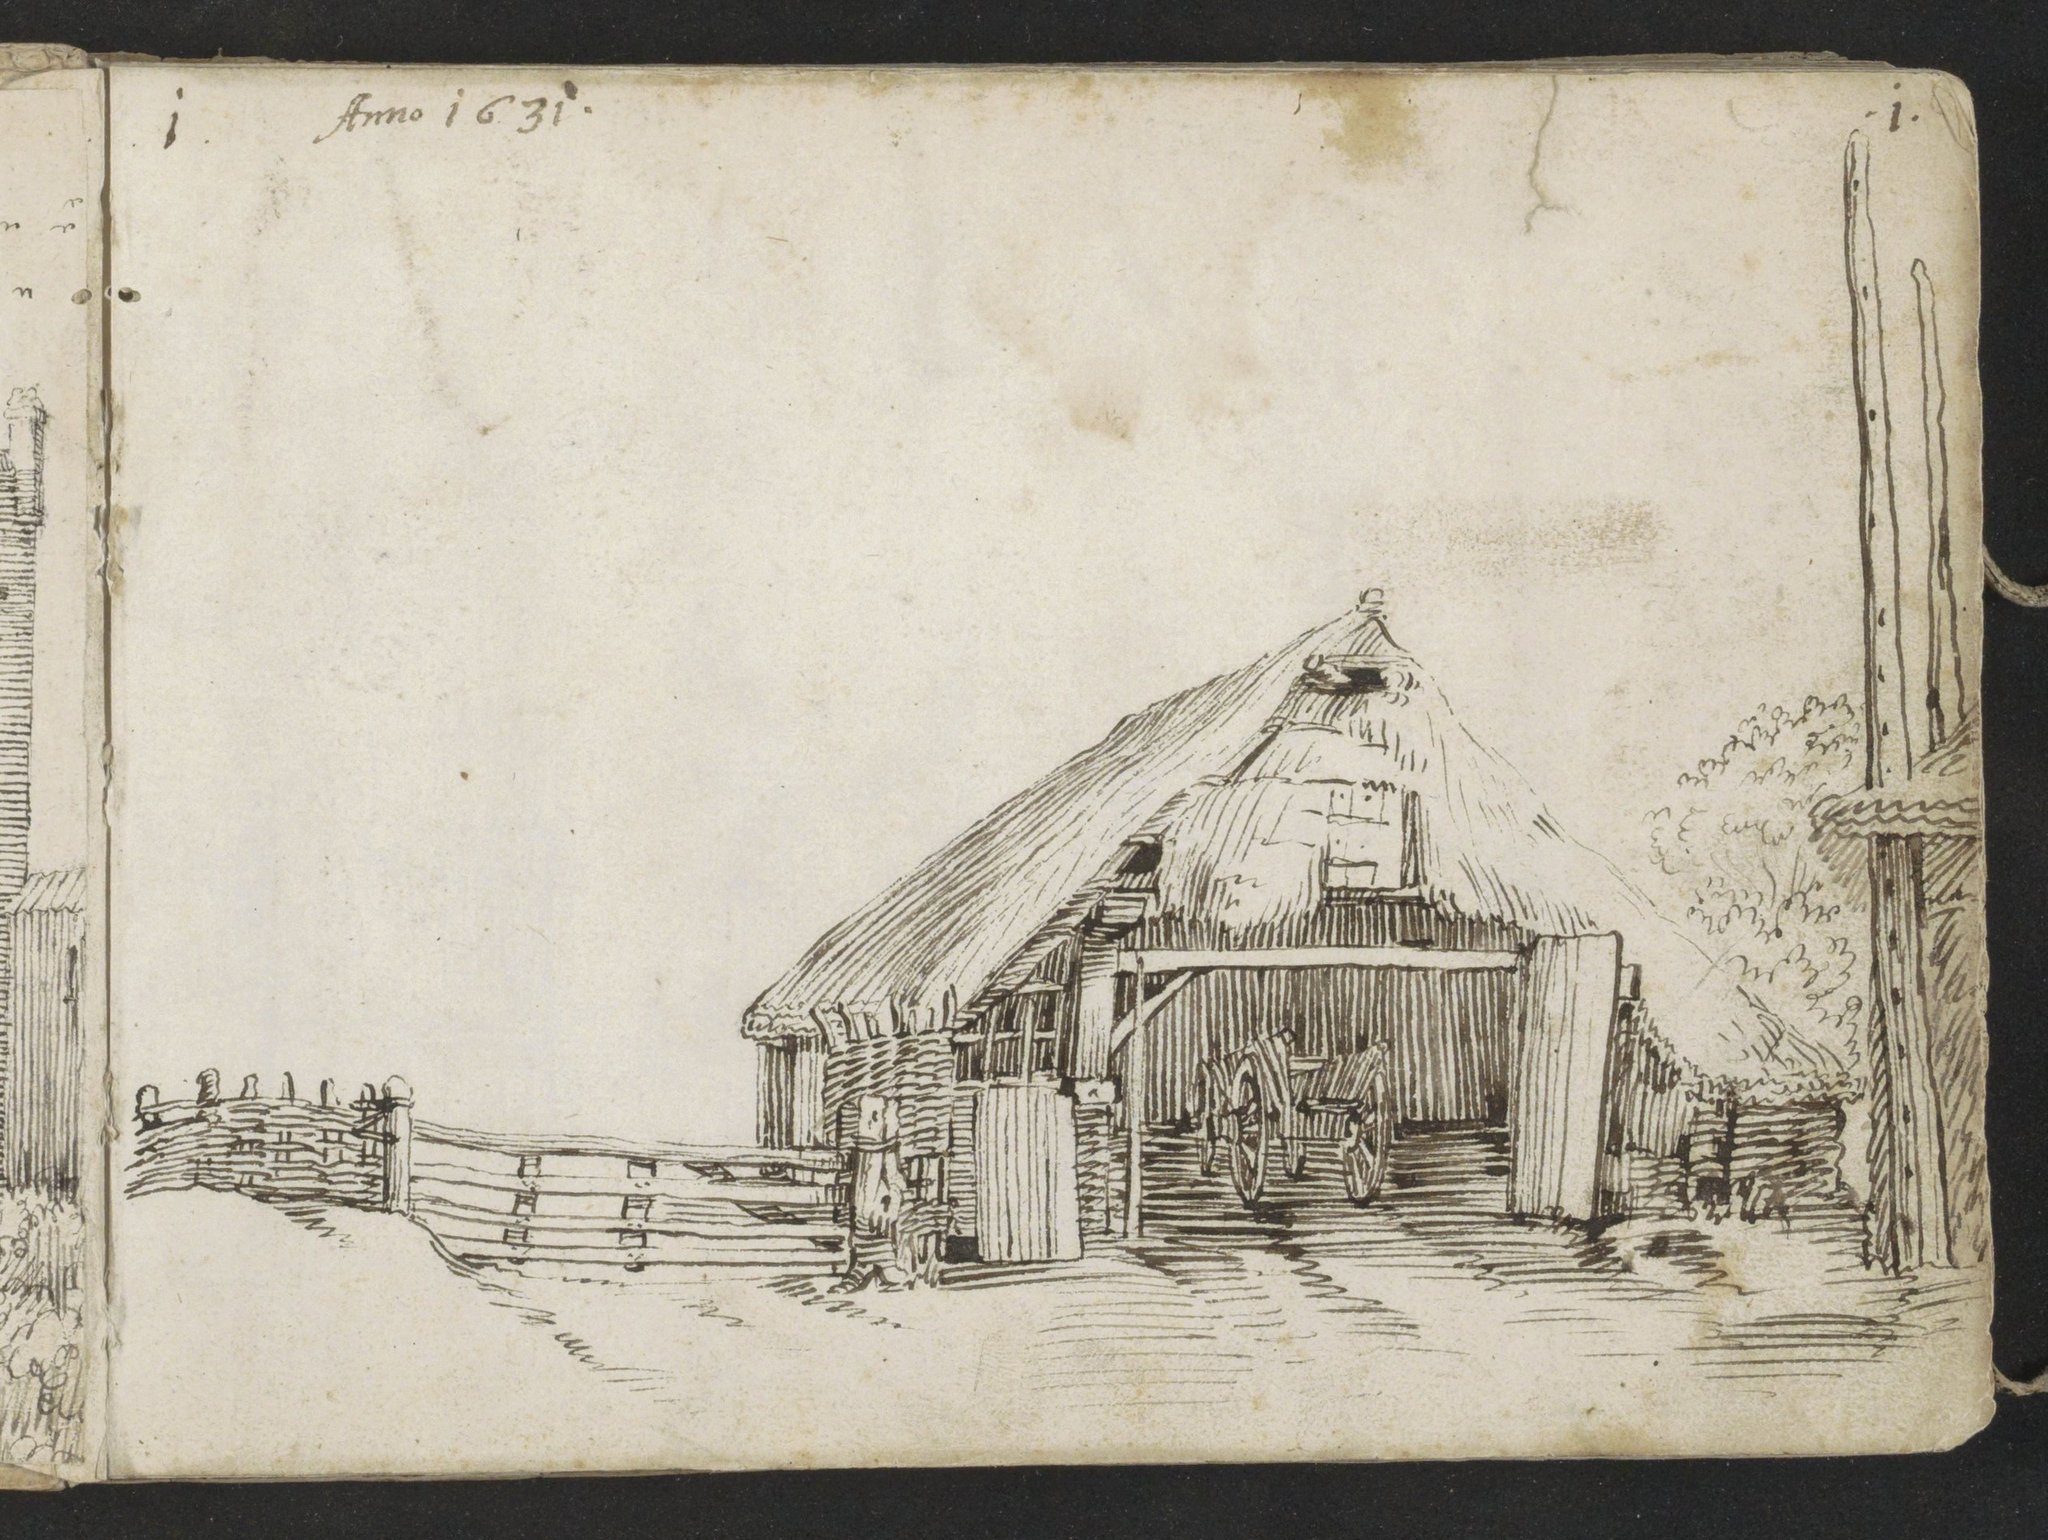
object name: sketchbook leaf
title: Trekkar in een hooischuur buiten Zwolle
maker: gerard ter borch (ii)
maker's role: draughtsman, painter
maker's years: 1617-1681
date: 1631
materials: ink, paper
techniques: pen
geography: zwolle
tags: hand-cart, barn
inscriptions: date: ‘Anno 1631.’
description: Blad 1 recto uit een schetsboek met 55 bladen.